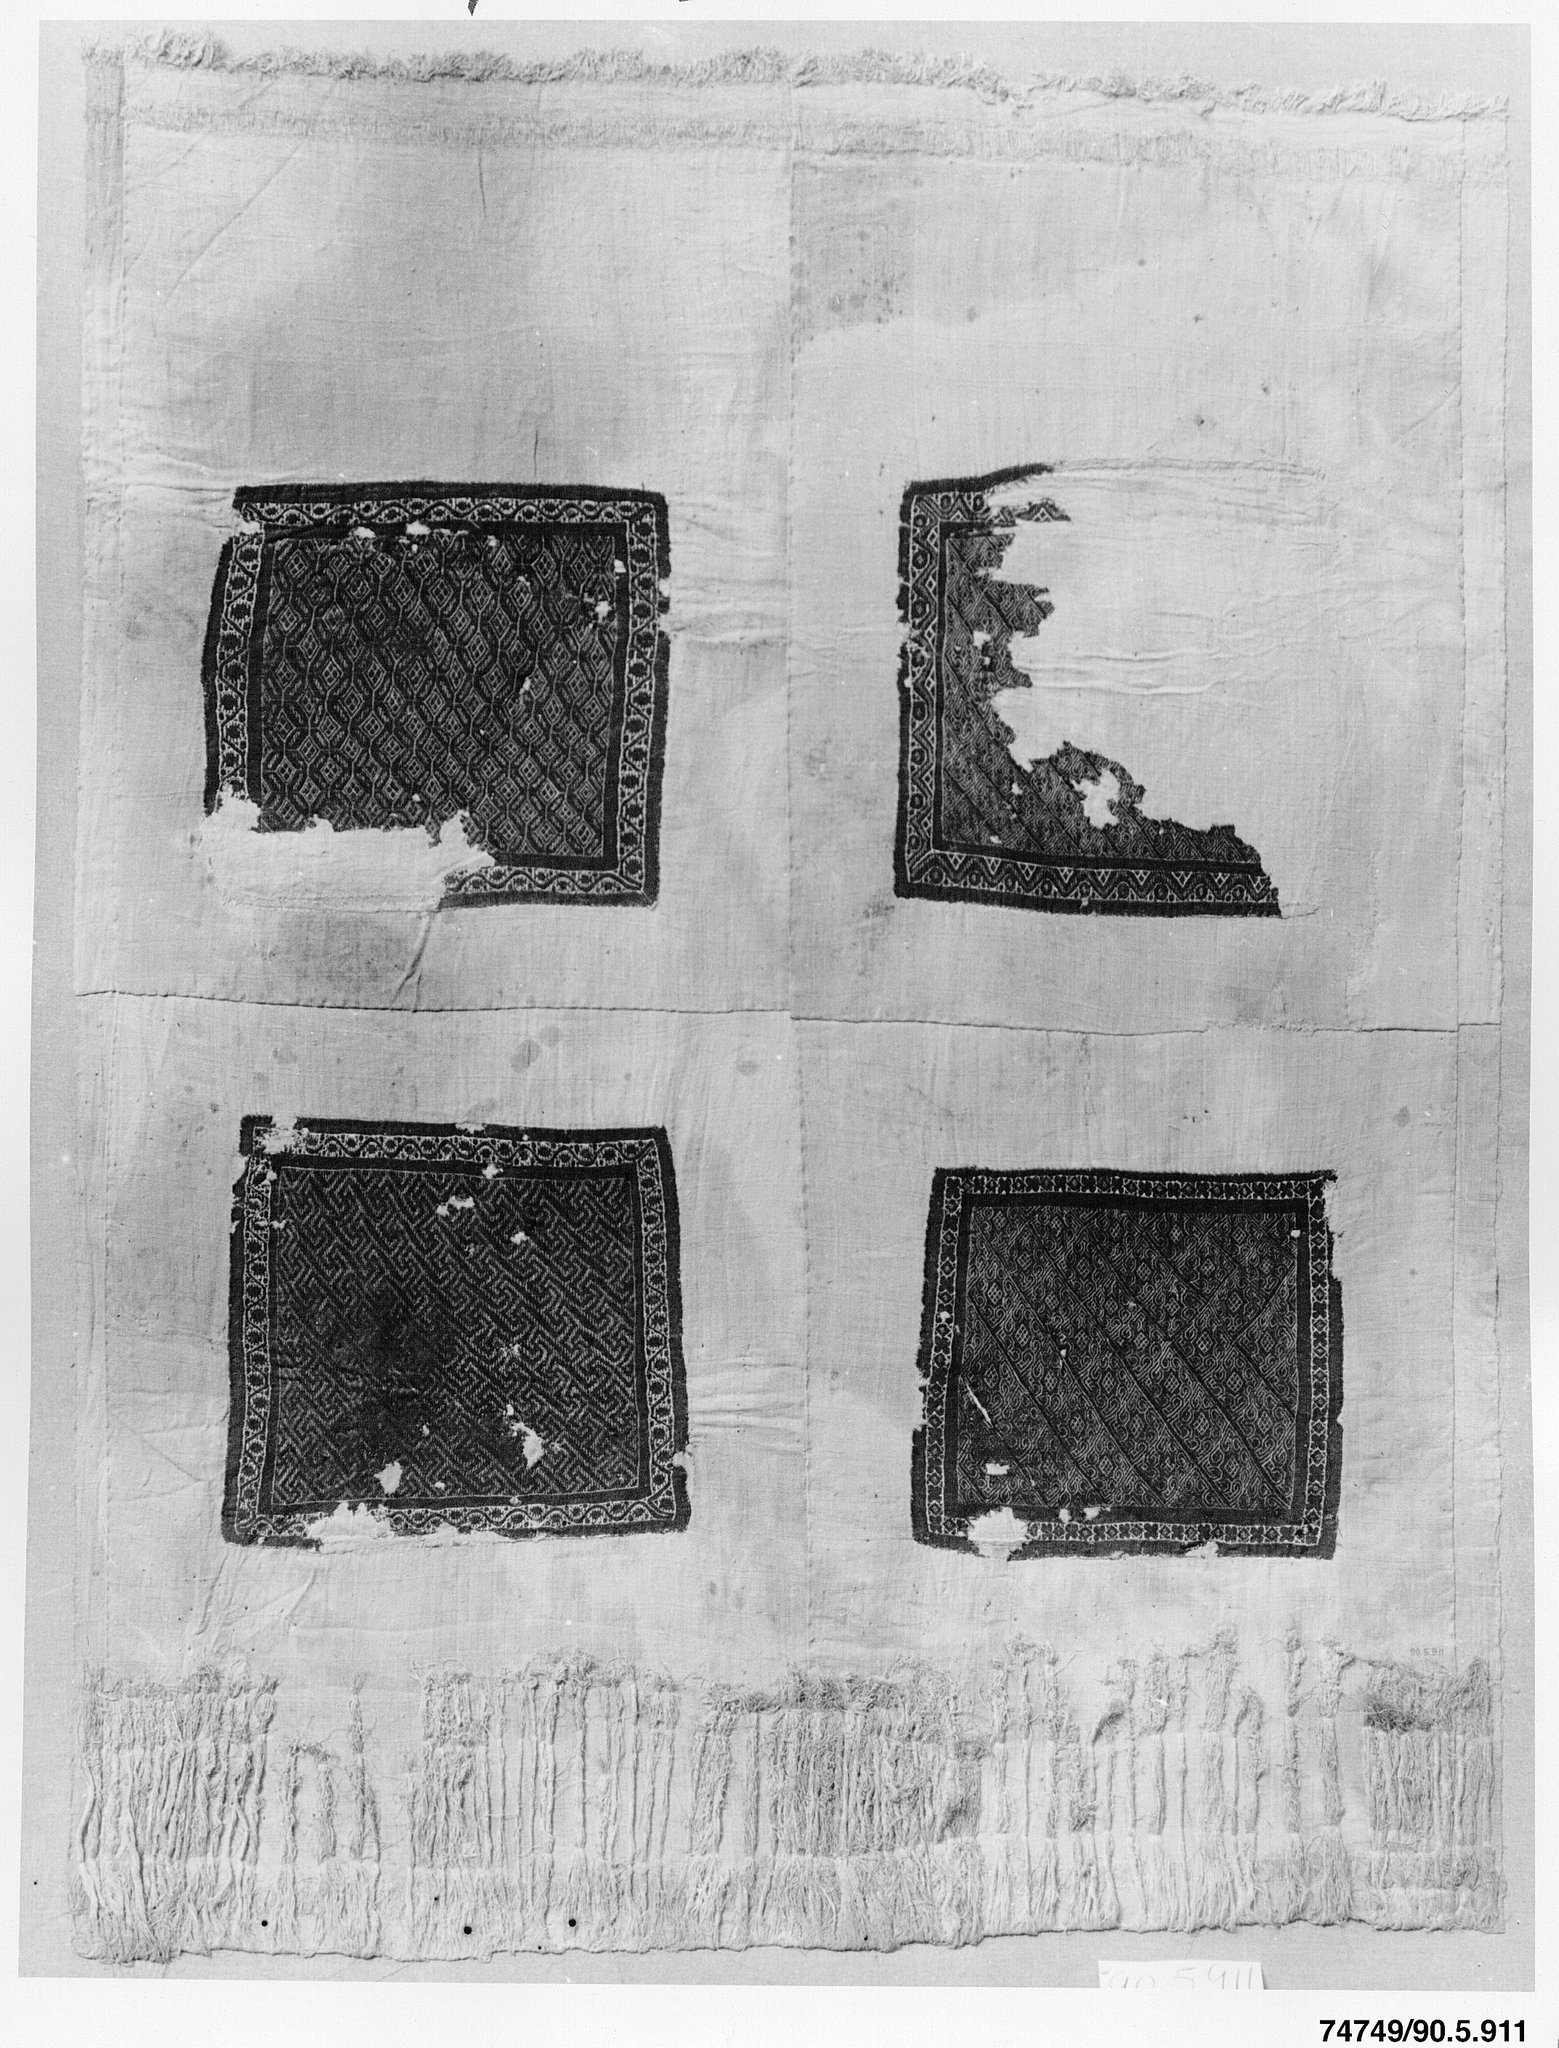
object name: textile fragment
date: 201-400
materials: linen, wool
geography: egypt